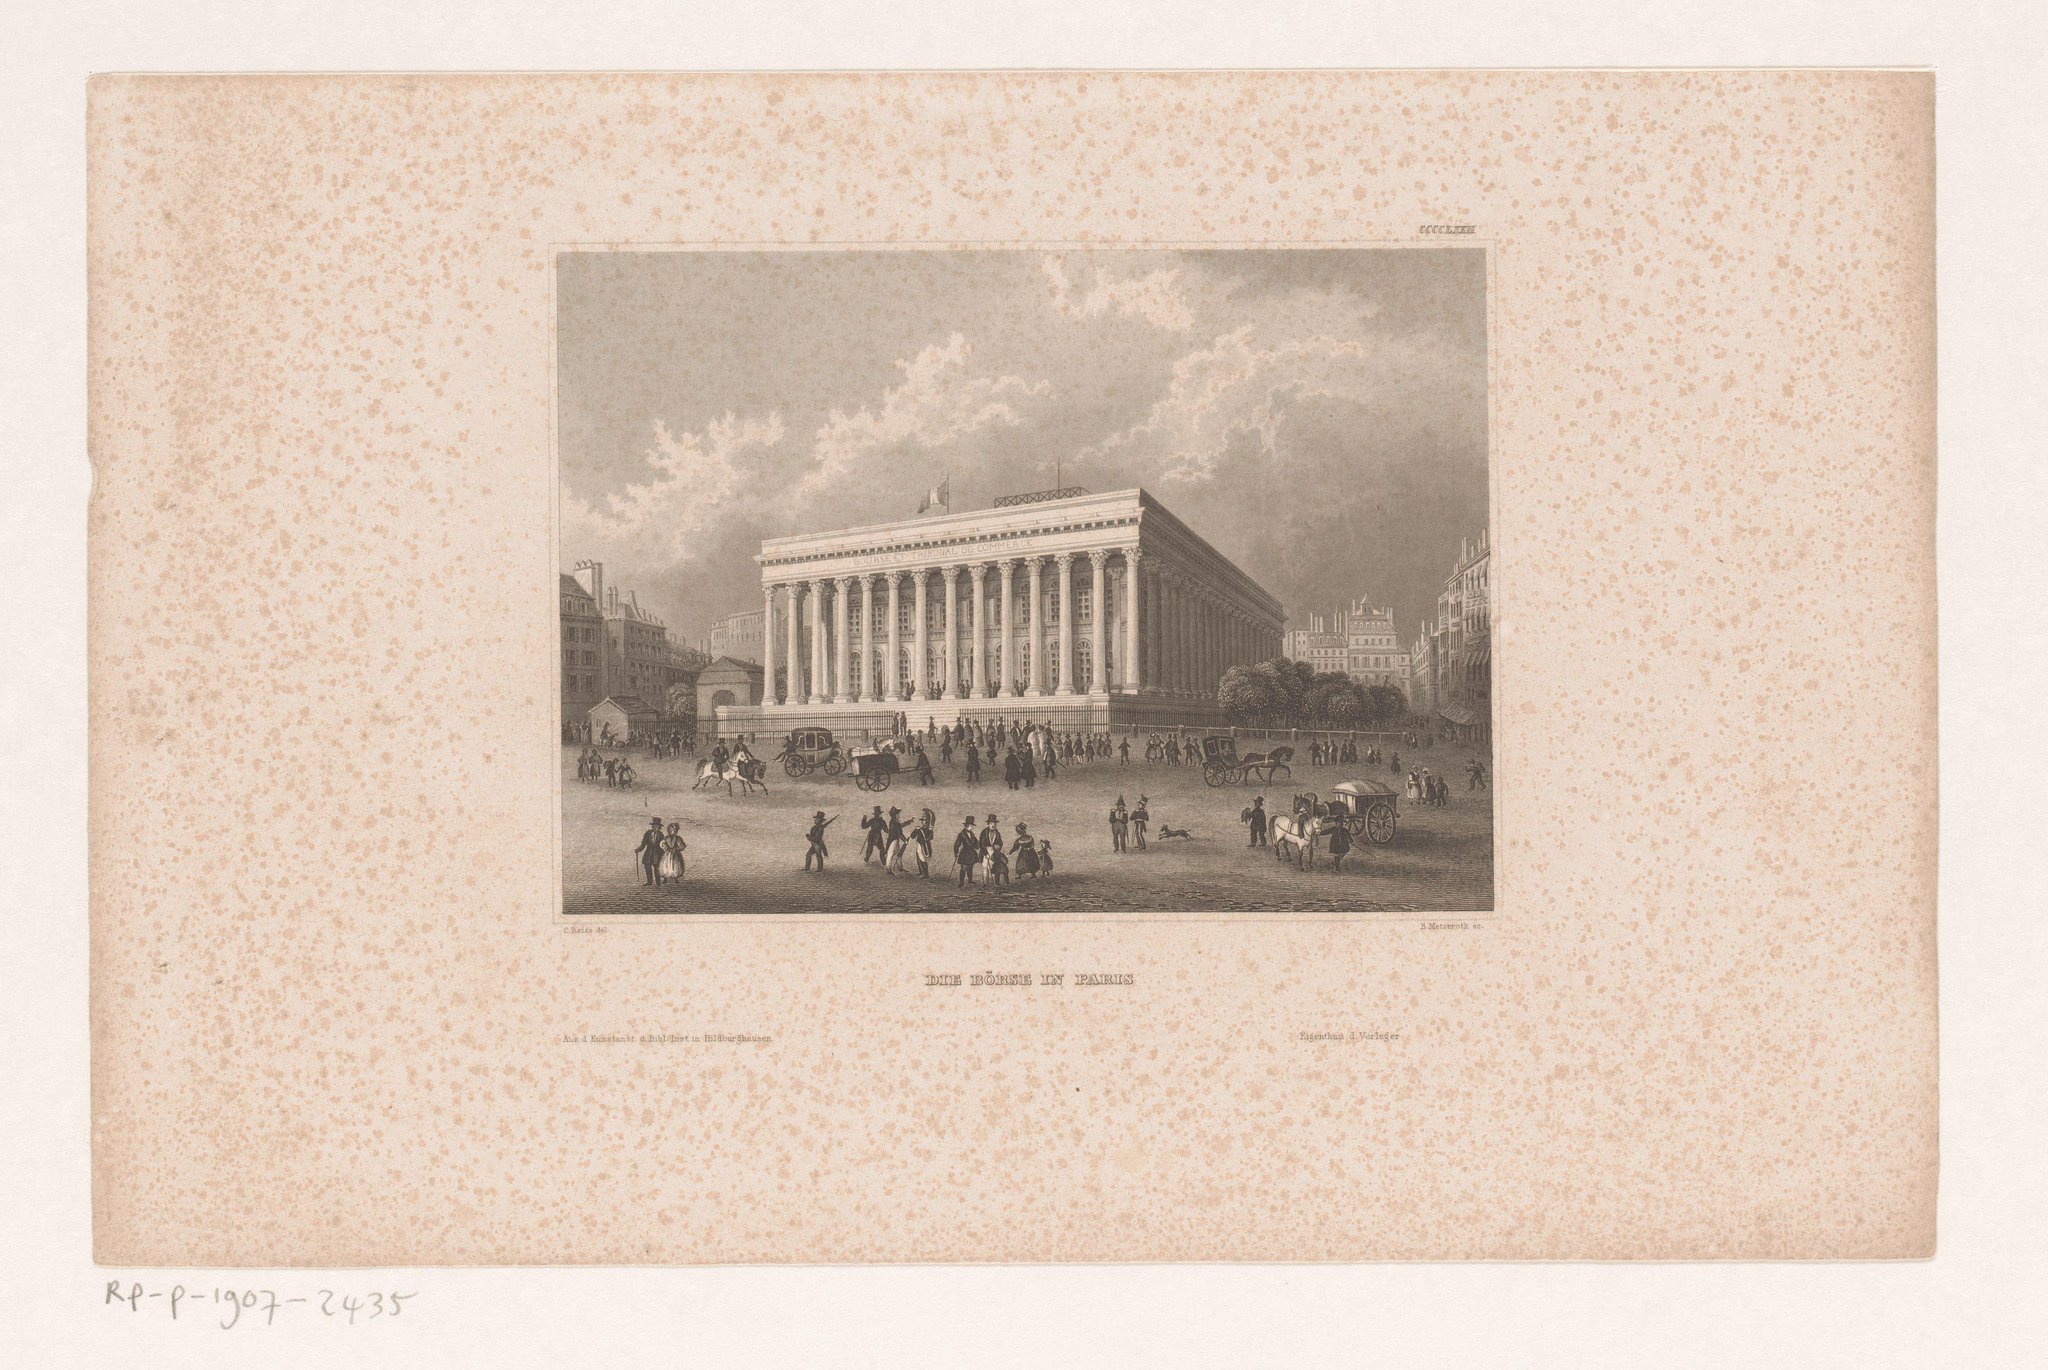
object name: print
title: Die Börse in Paris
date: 1850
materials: paper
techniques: engraving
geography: hildburghausen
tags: city-view in general; 'veduta', stock exchange, stock-market, paris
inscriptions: collector's mark: Lugt 2228